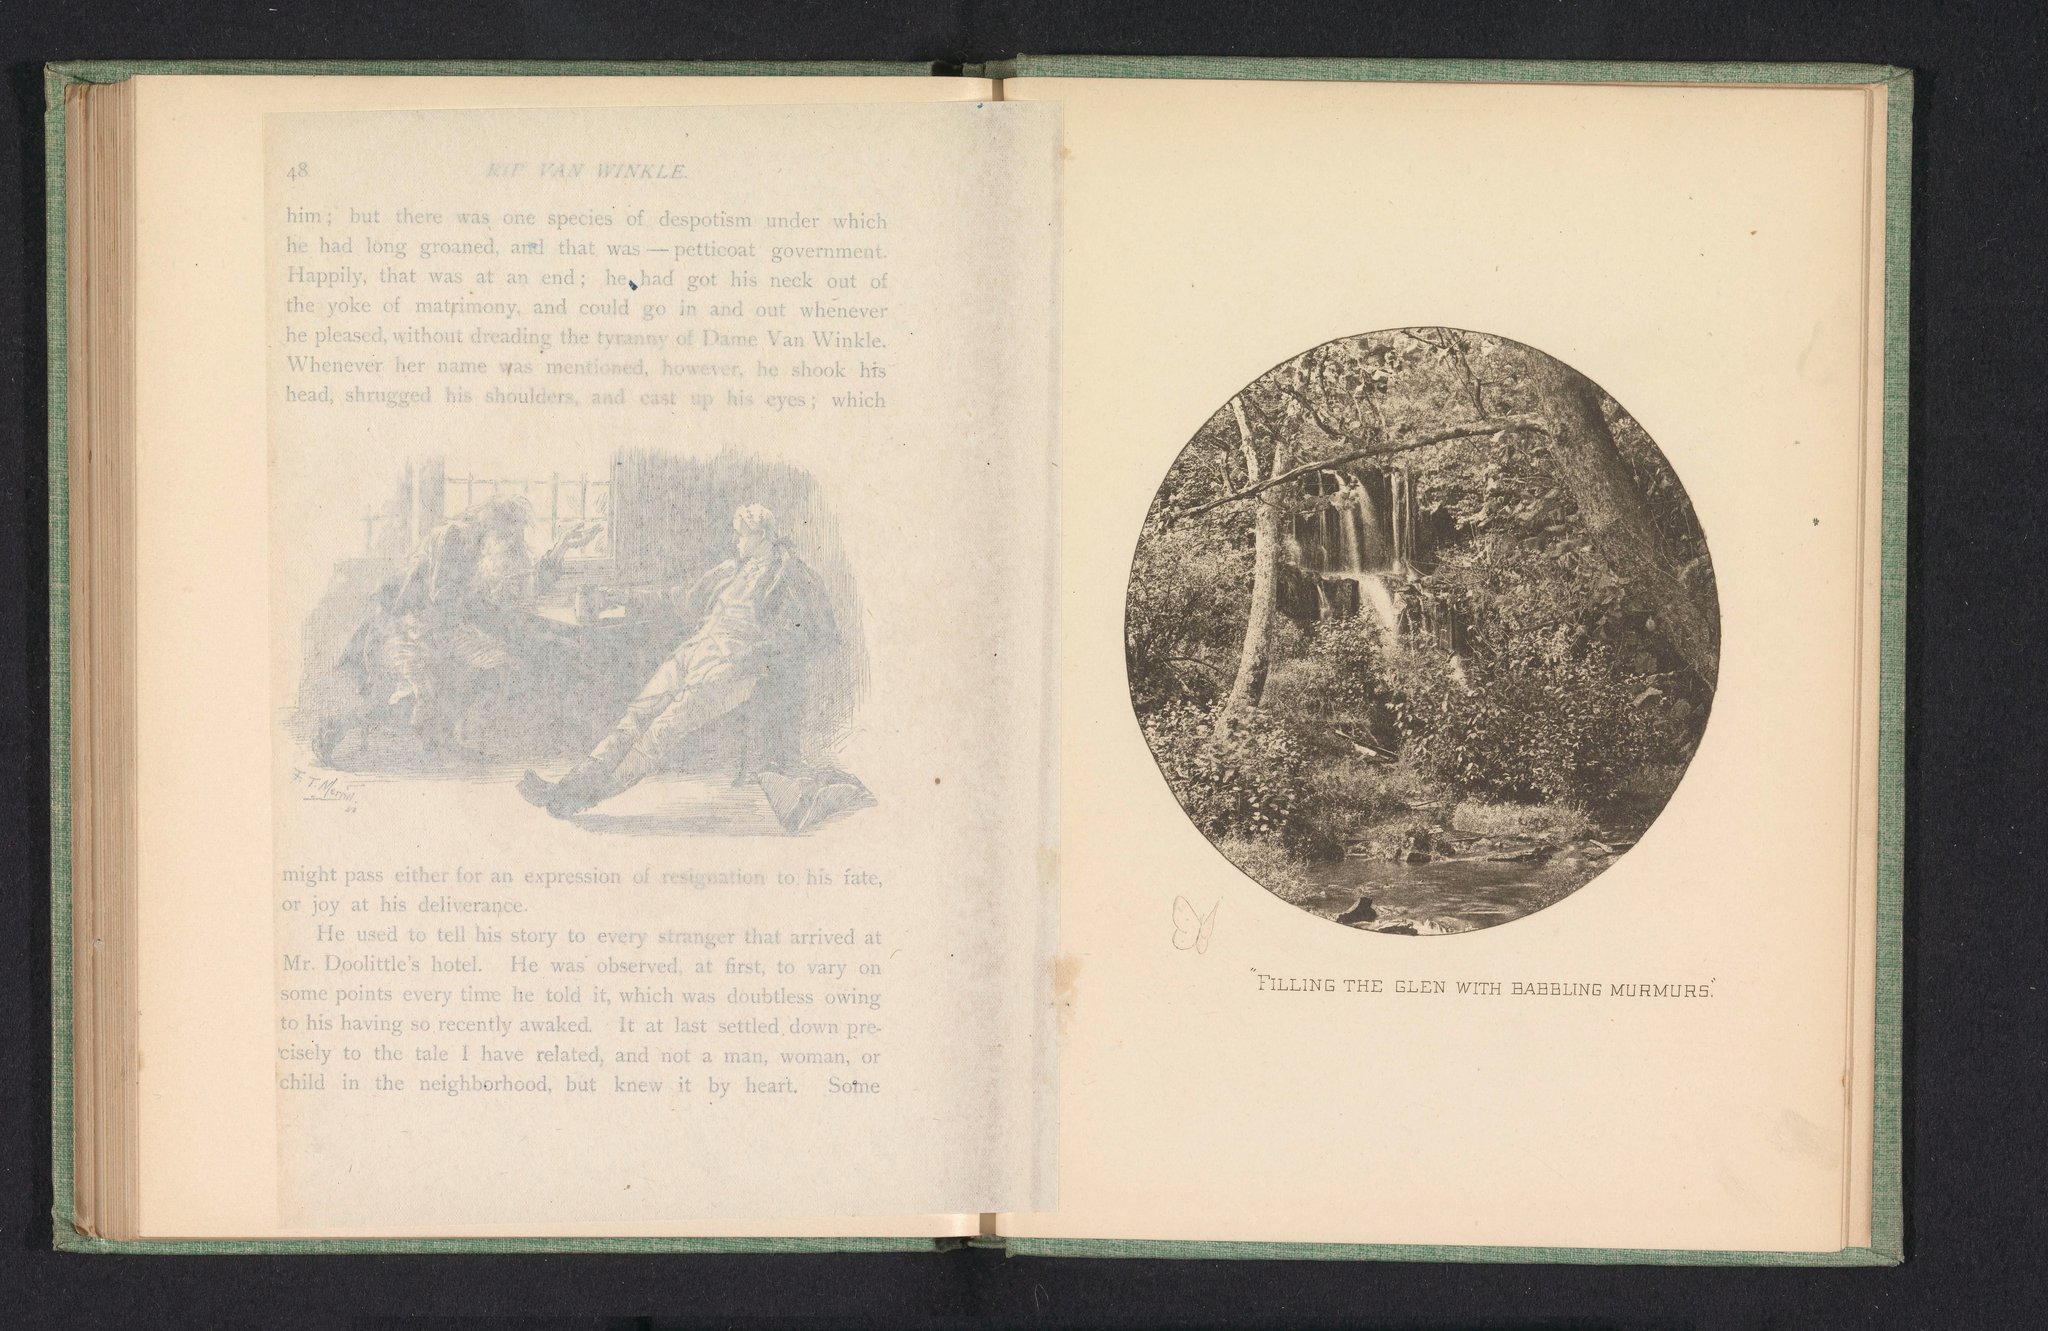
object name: photomechanical print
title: Gezicht op een waterval in het Catskillgebergte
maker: Anonymous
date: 1884-1894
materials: paper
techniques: photoaquatint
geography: catskill mountains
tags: waterfall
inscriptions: inscription: ‘“Filling the glen with babbling murmurs.”’